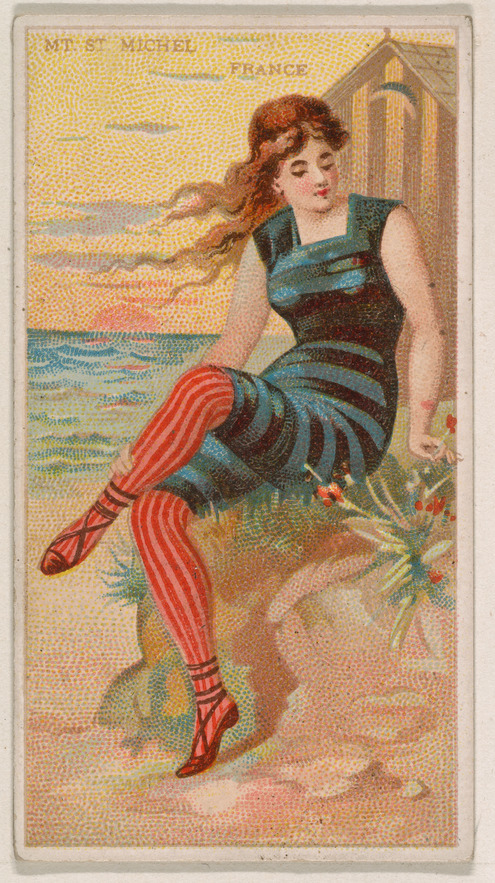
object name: print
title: Mt. St. Michel, France, from the Surf Beauties series (N232), issued by Kinney Bros.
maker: kinney brothers tobacco company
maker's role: publisher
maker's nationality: american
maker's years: 1869-2011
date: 1889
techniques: color lithograph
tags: women